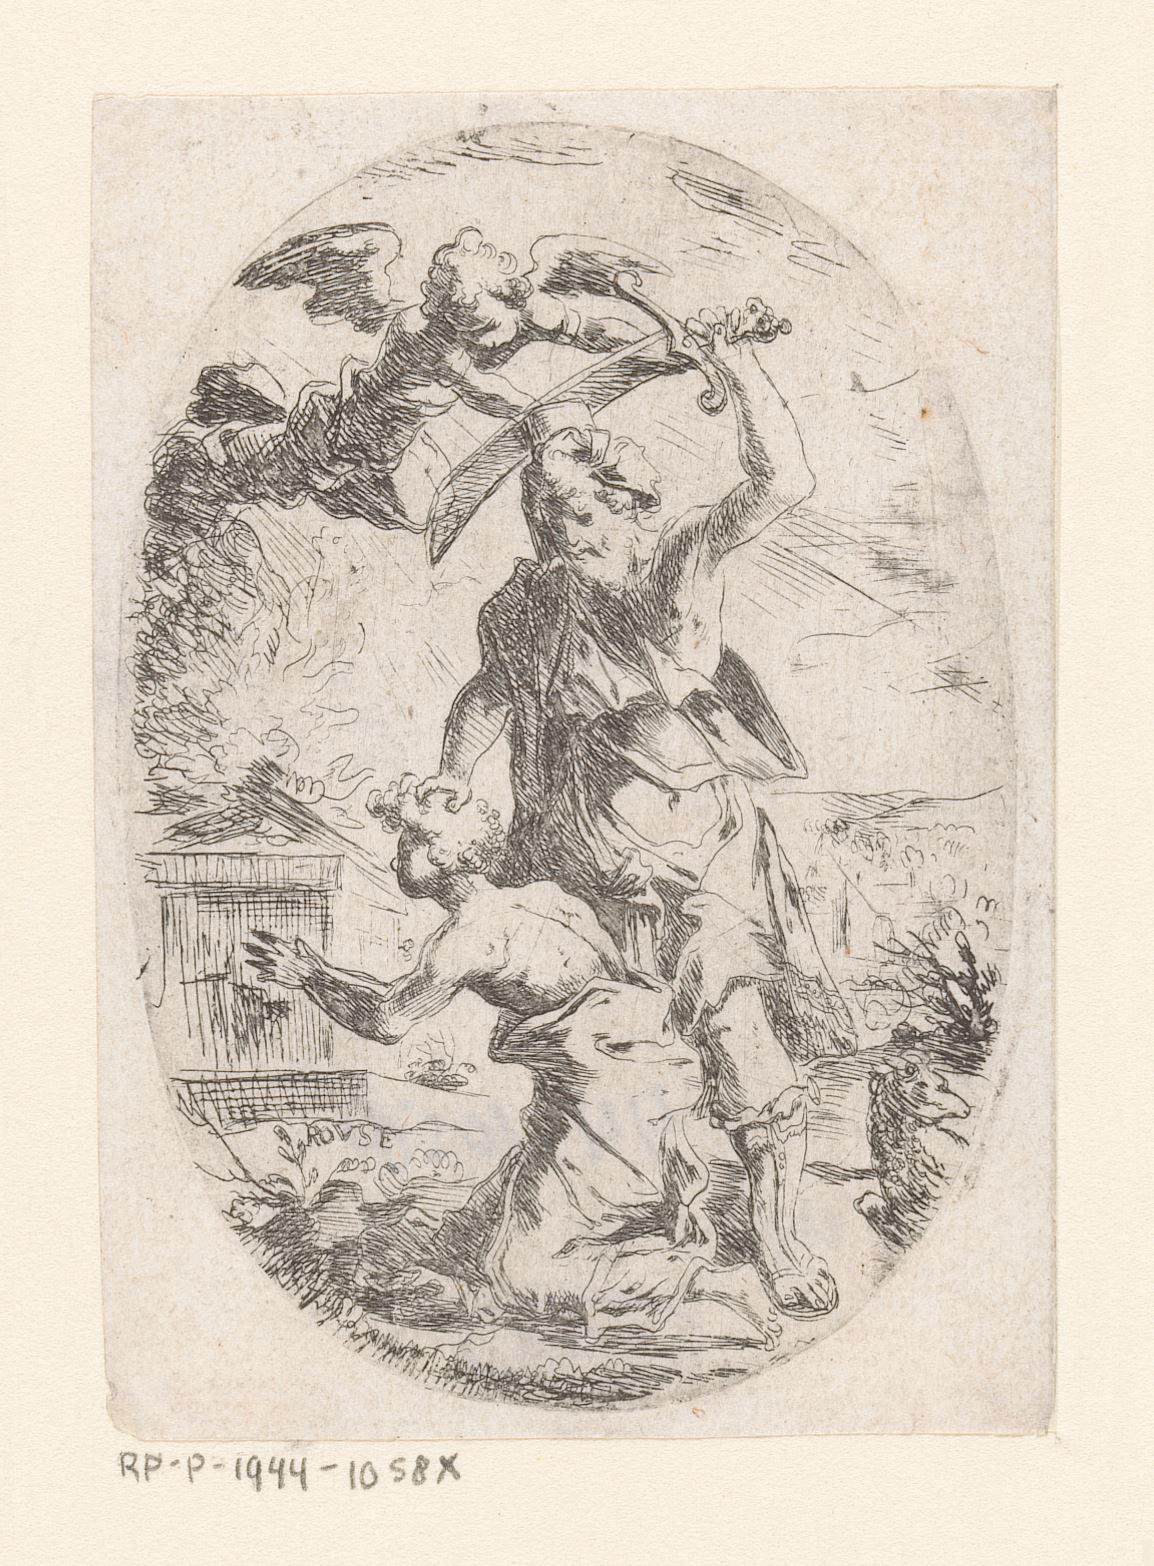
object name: print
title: Offer van Isaak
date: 1600-1699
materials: paper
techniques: etching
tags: when abraham has his hand raised to kill isaac, god or the hand of god restrains abraham's hand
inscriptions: collector's mark: Lugt 2228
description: Abraham staat op het punt om zijn zoon Isaak te offeren. Een engel houdt hem tegen.